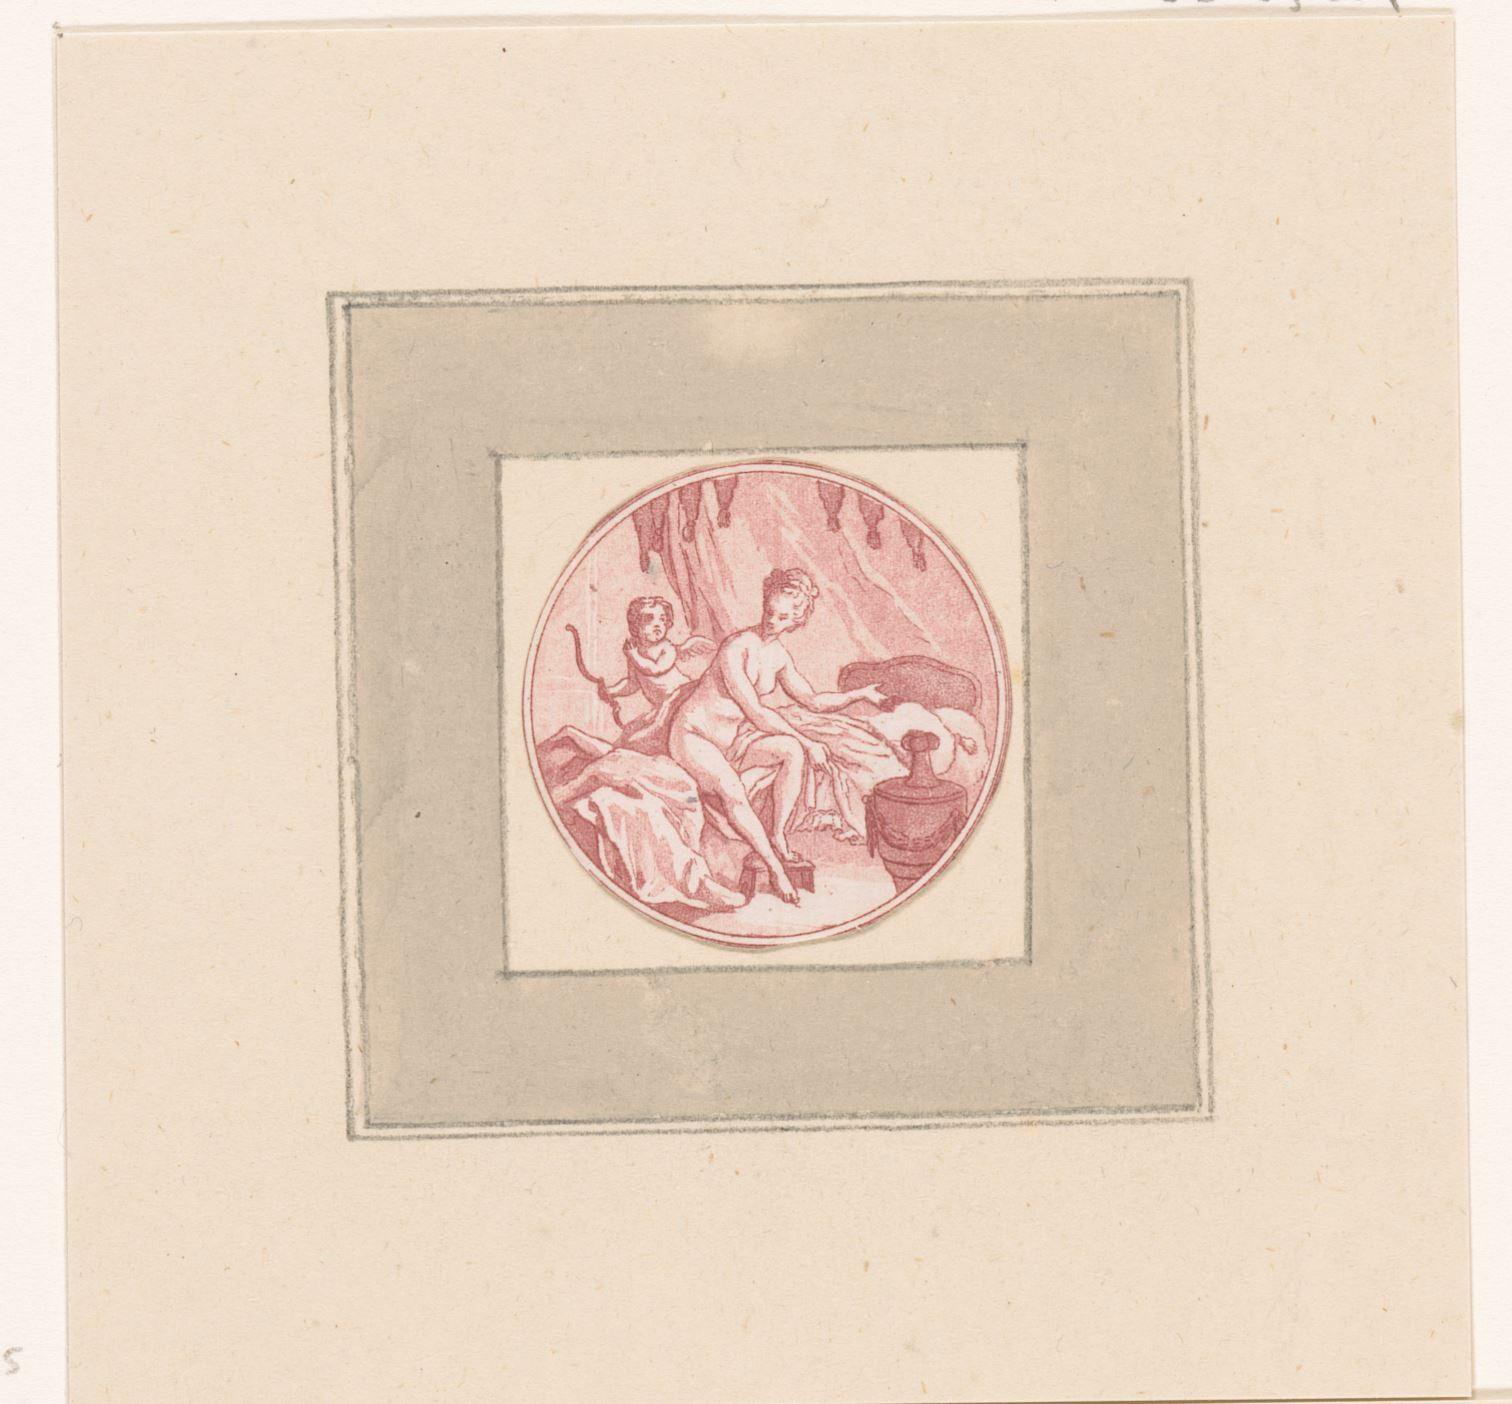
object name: print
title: Venus en Amor op een bed gezeten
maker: jean baptist leprince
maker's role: draughtsman, print maker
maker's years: 1734-1781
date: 1744-1781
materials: paper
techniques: aquatint, etching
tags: bed, (story of) venus (aphrodite)